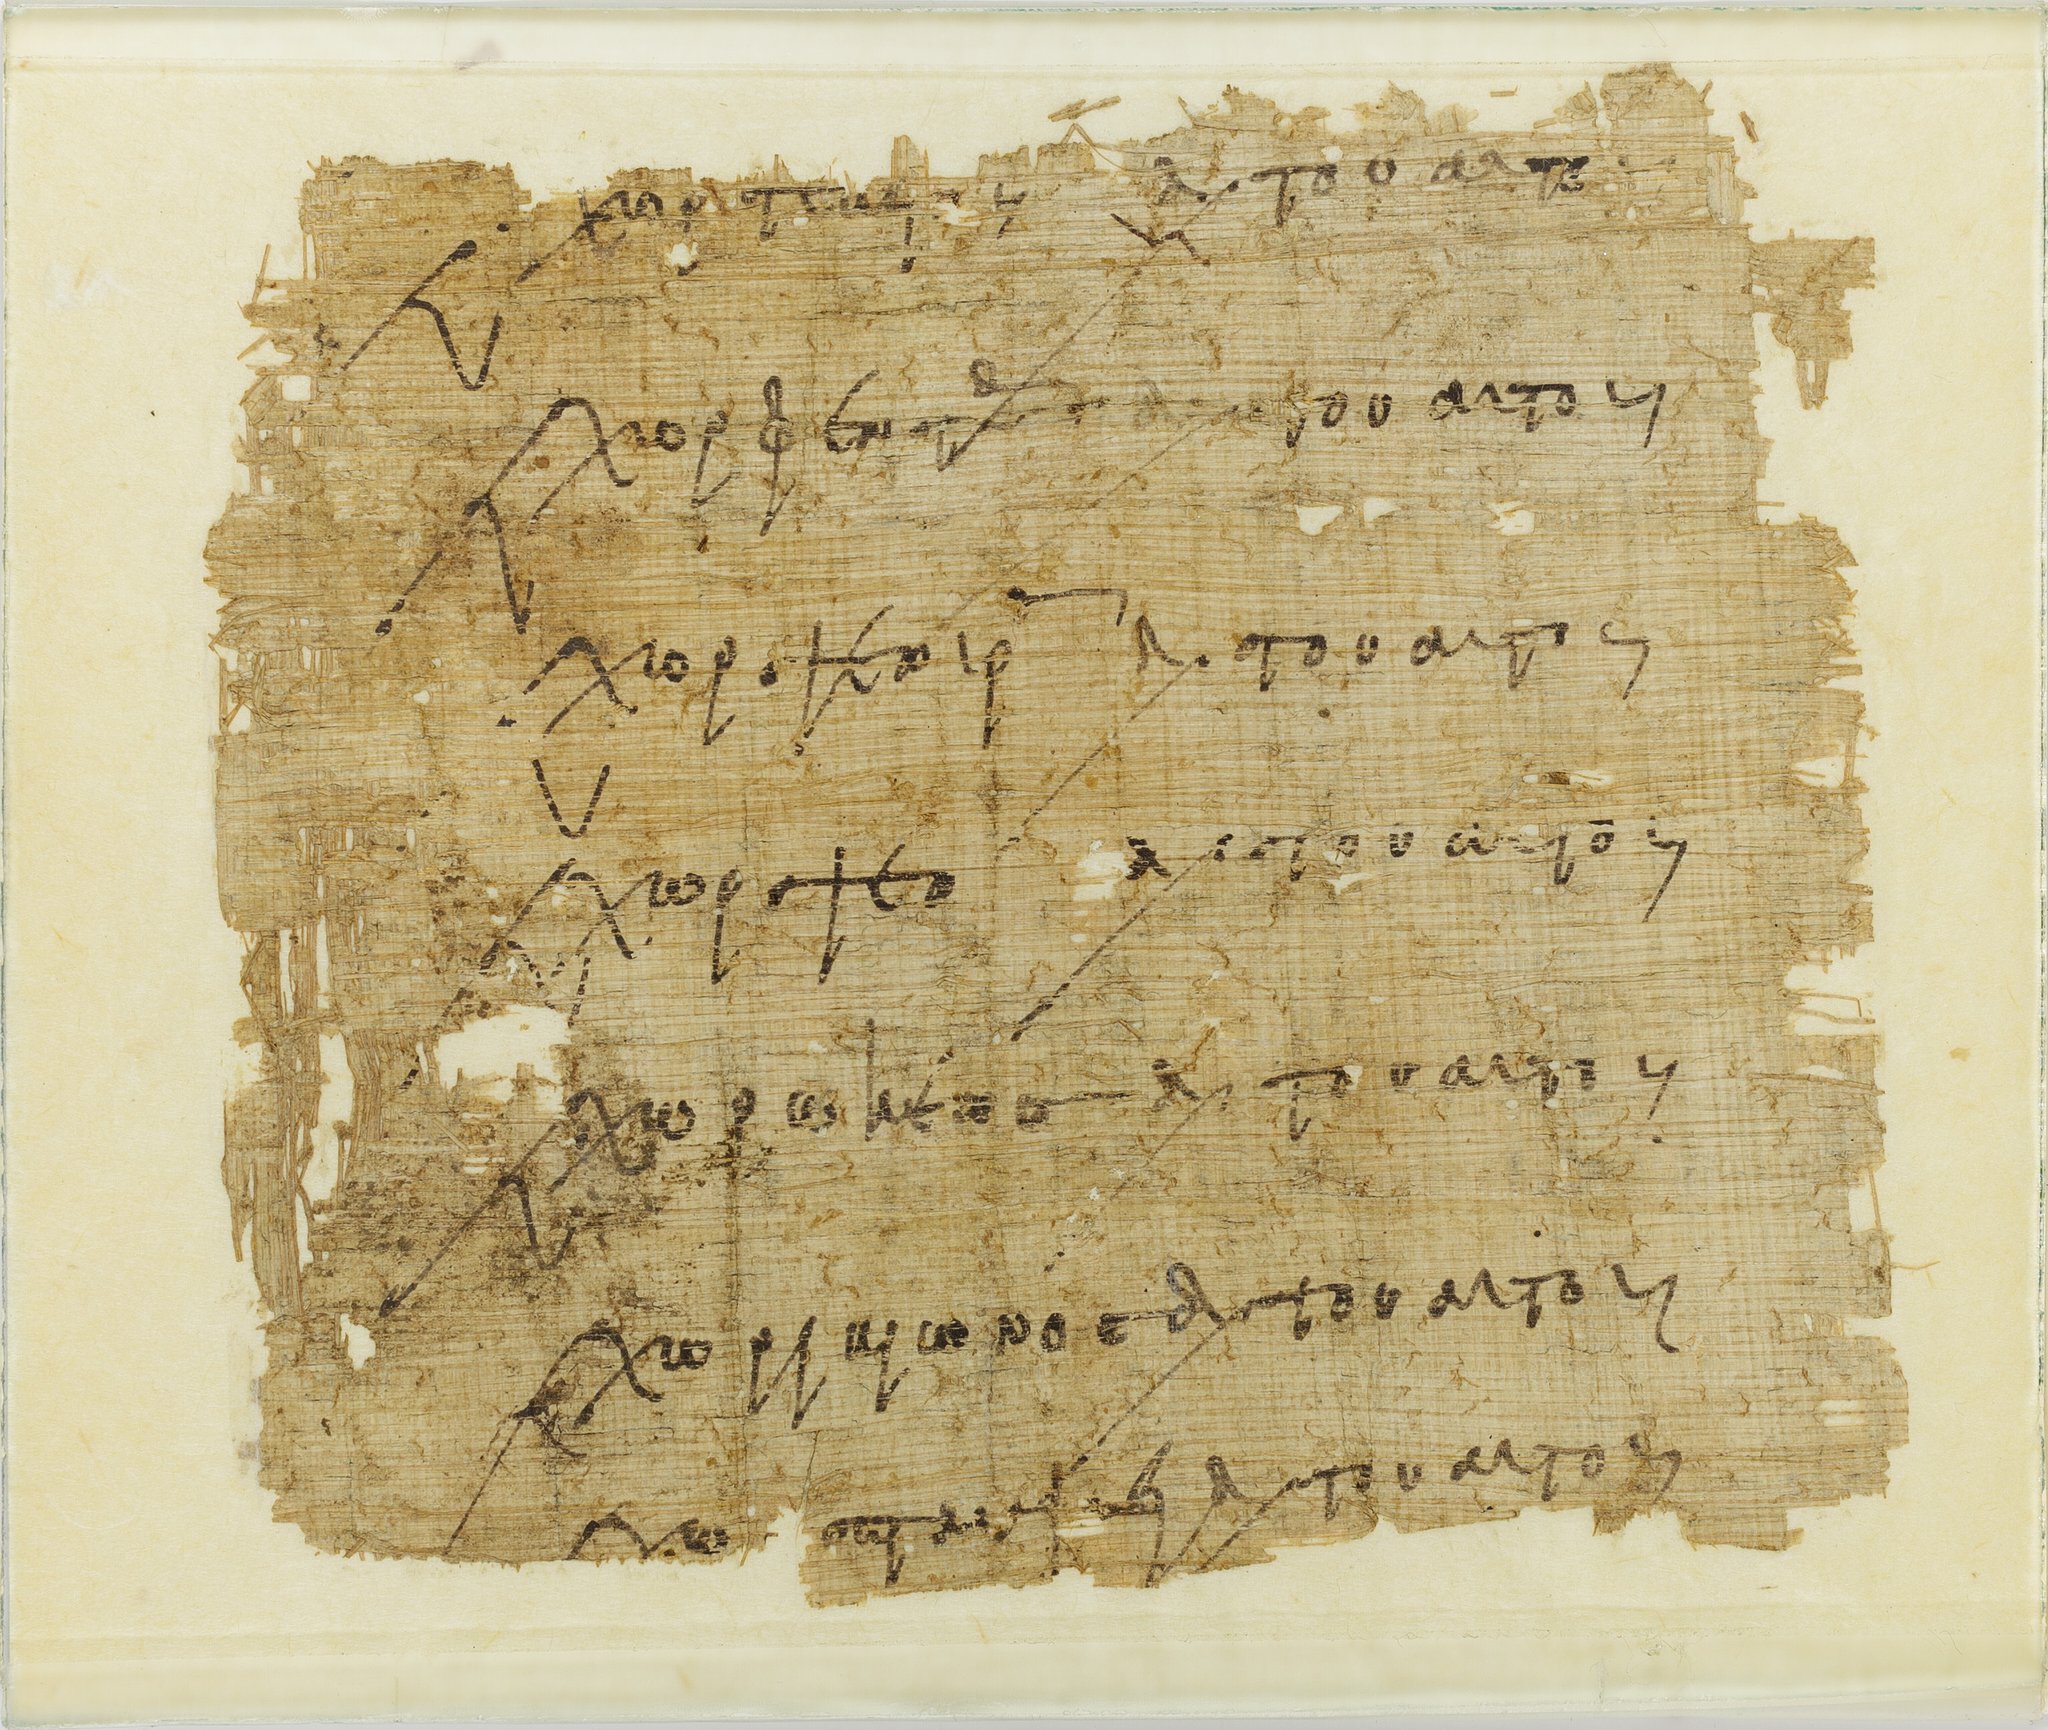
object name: papyrus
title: Papyrus fragment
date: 301-400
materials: ink, papyrus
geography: egypt